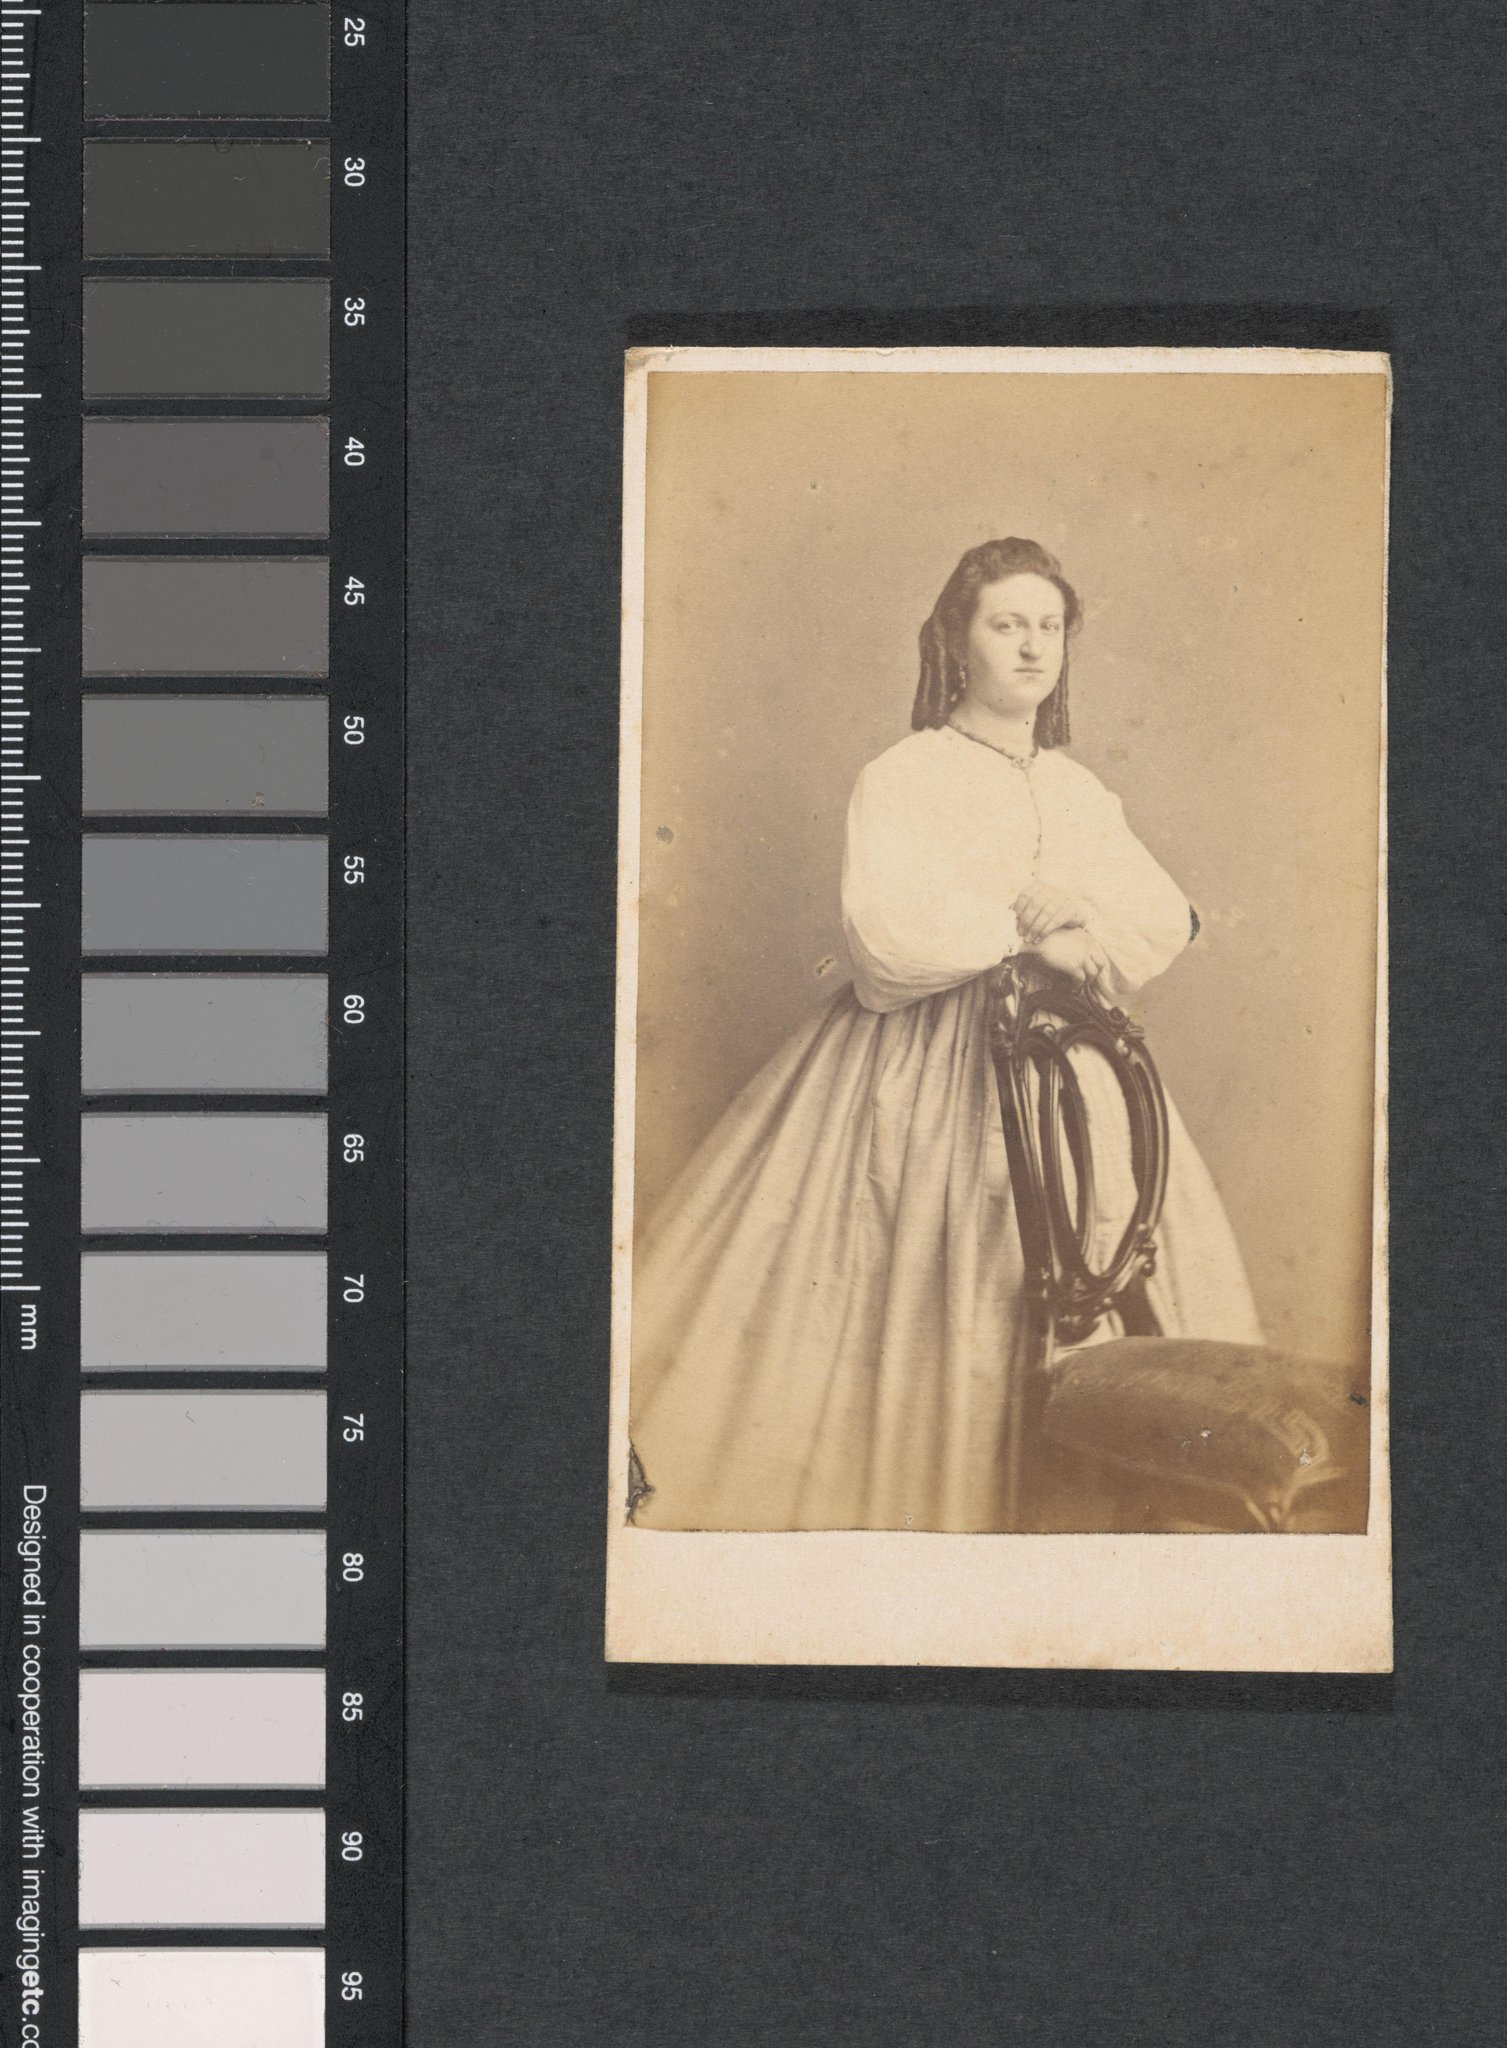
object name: photograph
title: Portret van een onbekende vrouw uit de familie Marmelstein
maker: j. korsten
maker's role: fotograaf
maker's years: 1841-1878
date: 1864-1878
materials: cardboard, photographic support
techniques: albumen print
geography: middelburg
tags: historical persons - bb - woman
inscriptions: inscription: ‘J. KORSTEN/ Kunstschilder/ en PHOTOGRAPHE/ MIDDELBURG.’